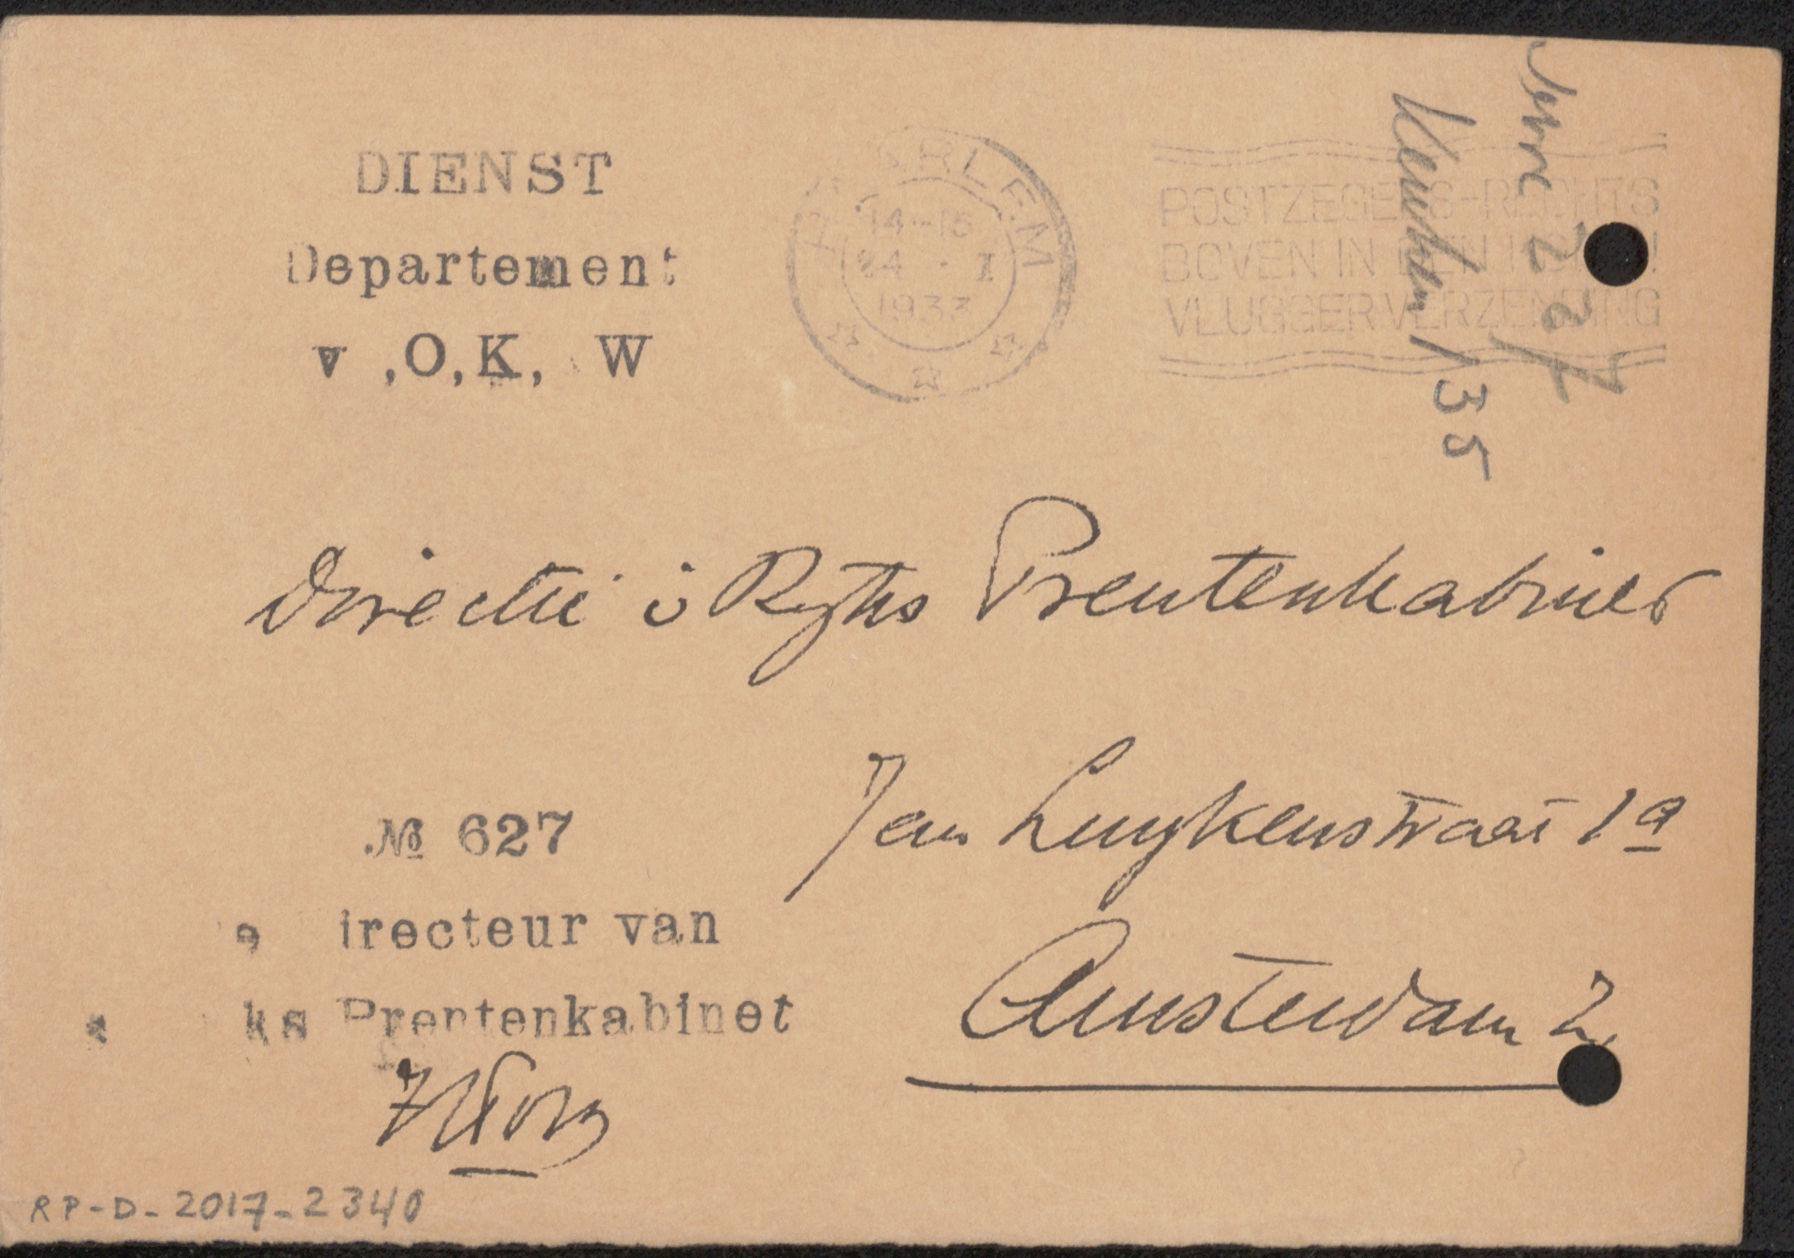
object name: letter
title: Brief aan jonkheer Hendrik Teding van Berkhout (1879-1969)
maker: elias voet jr.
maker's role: jeweler, print maker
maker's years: 1868-1940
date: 1932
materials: ink, paper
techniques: pen, writing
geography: bloemendaal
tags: amsterdam, jonkheer hendrik teding van berkhout (1879-1969)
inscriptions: name: ‘DIENST DEPARTEMENT v, O, K, & W No 627, De Directeur van s Rijks Prentenkabinet’